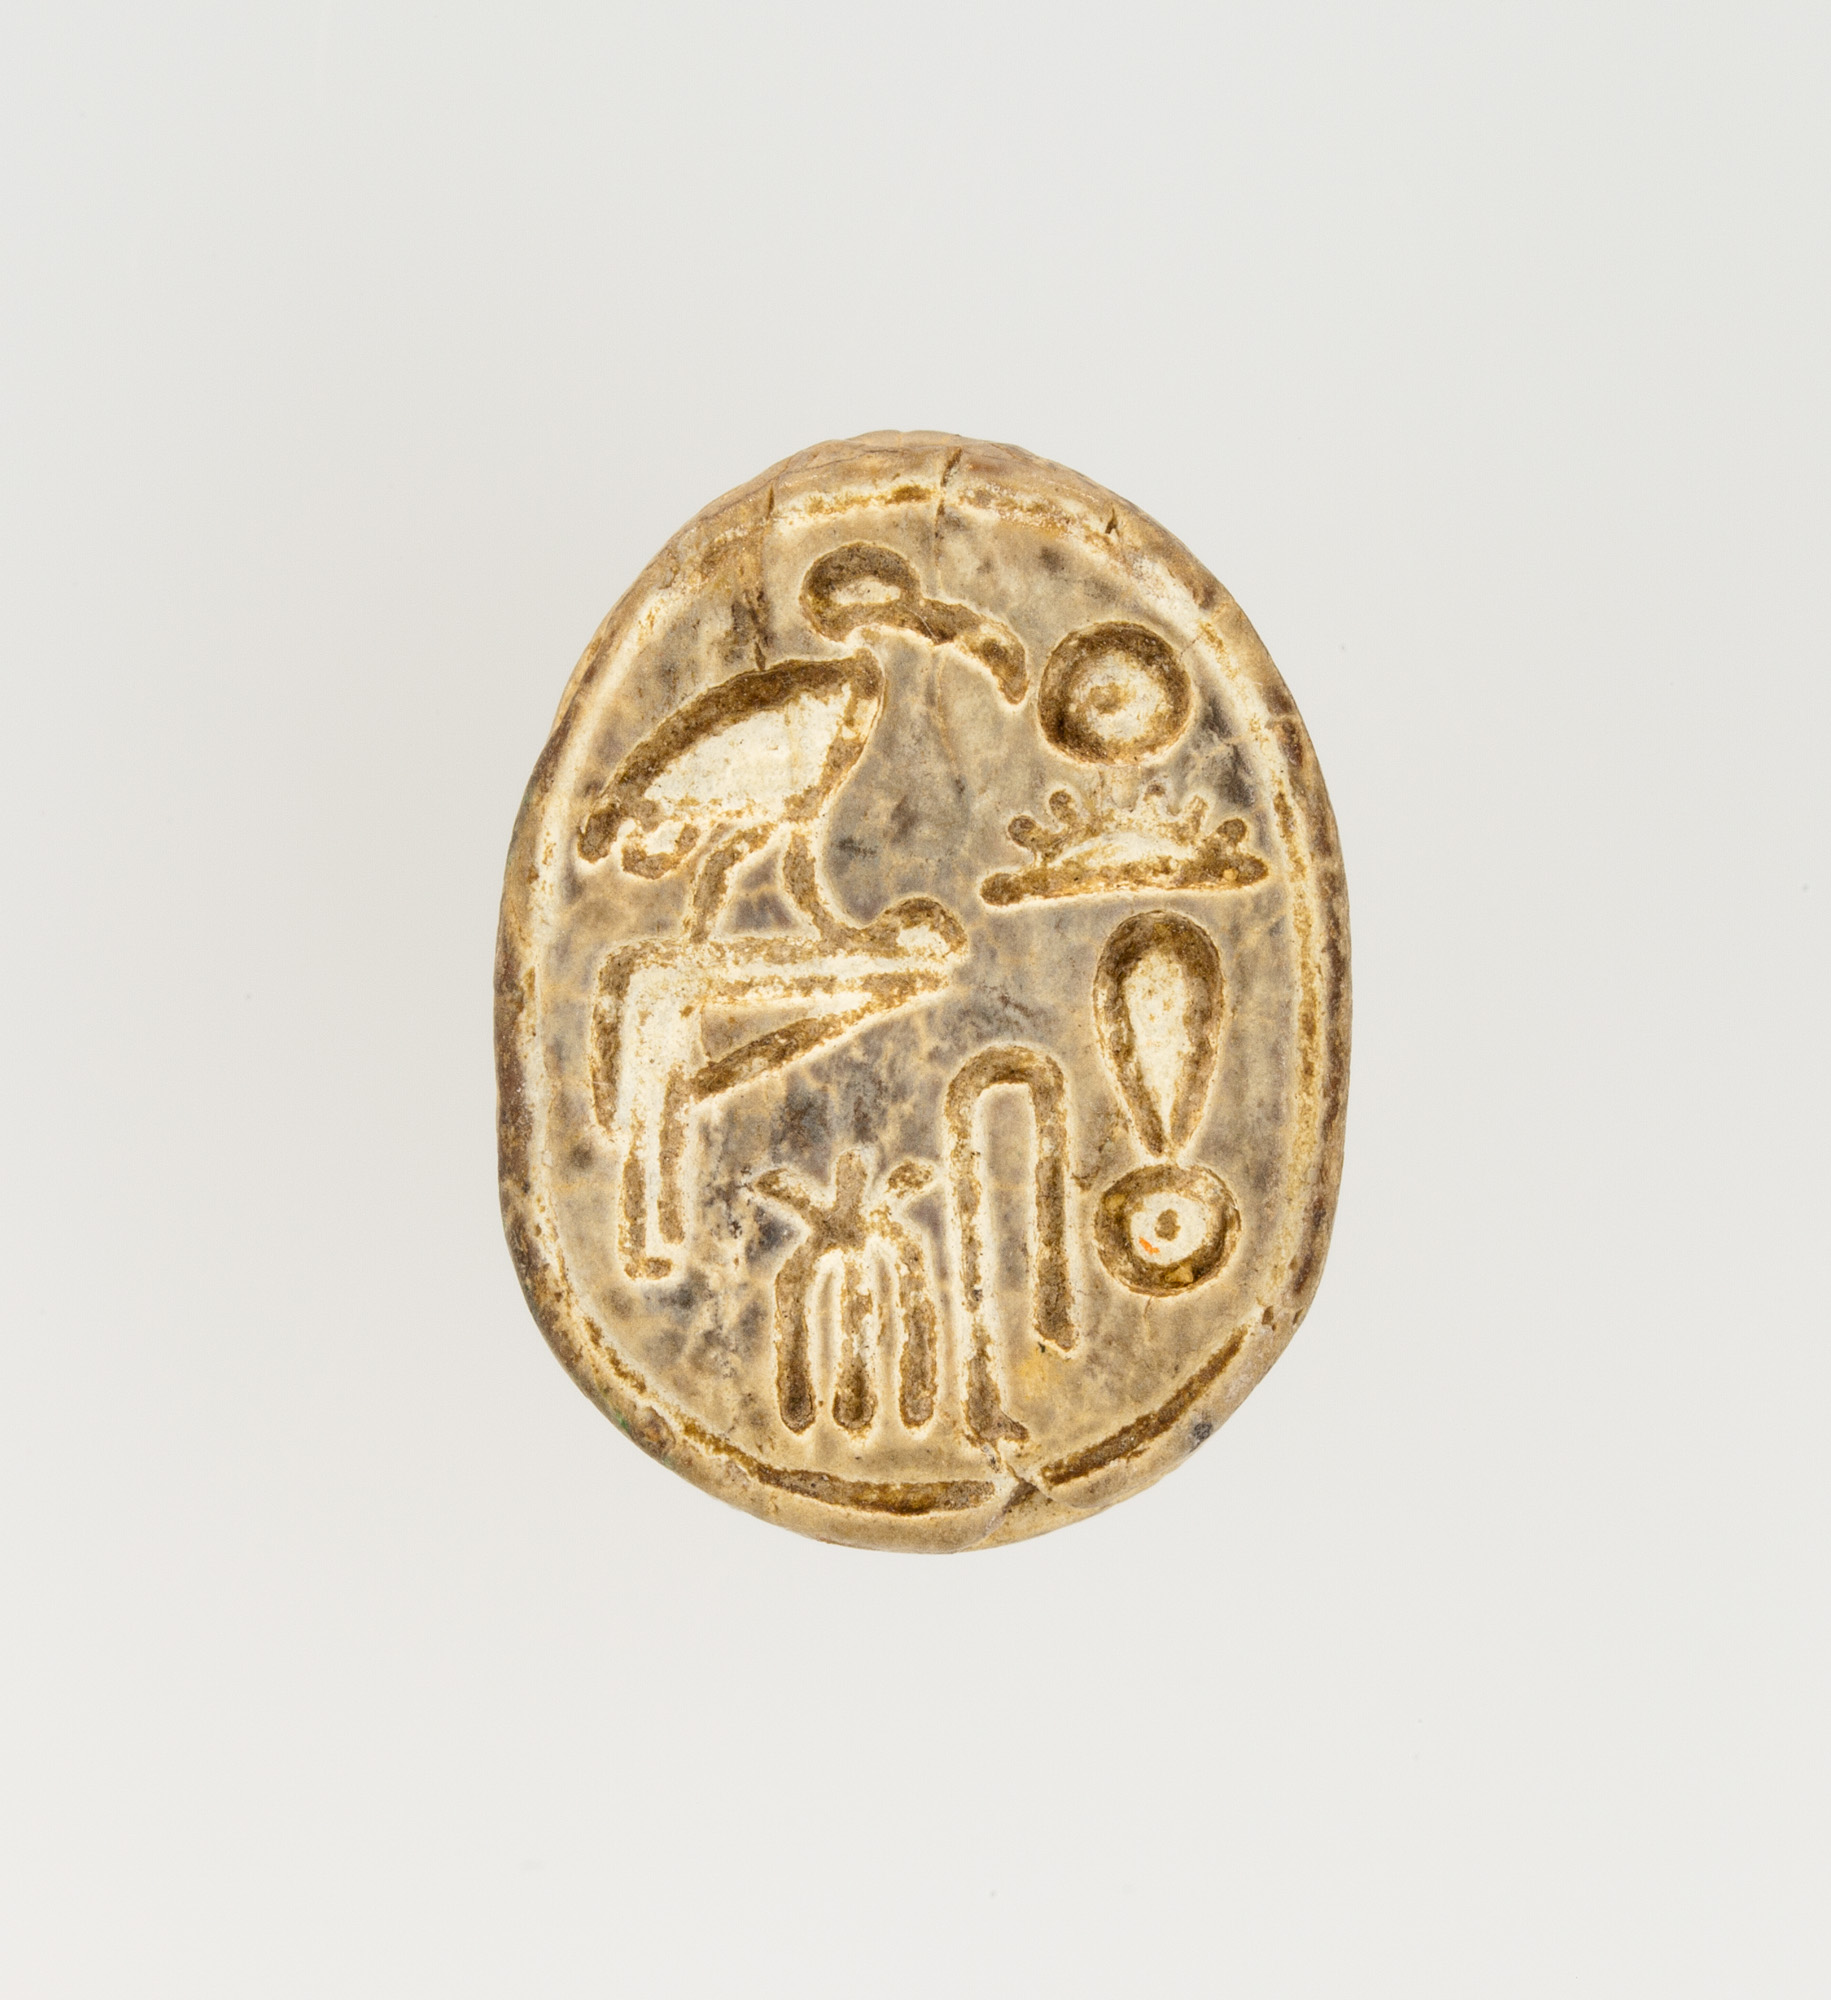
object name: scarab, thutmose i, appearing like re, kha mi re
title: Scarab Inscribed for Thutmose I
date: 1504-1492 BCE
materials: stone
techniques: glazing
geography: egypt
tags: hieroglyphs,scarabs